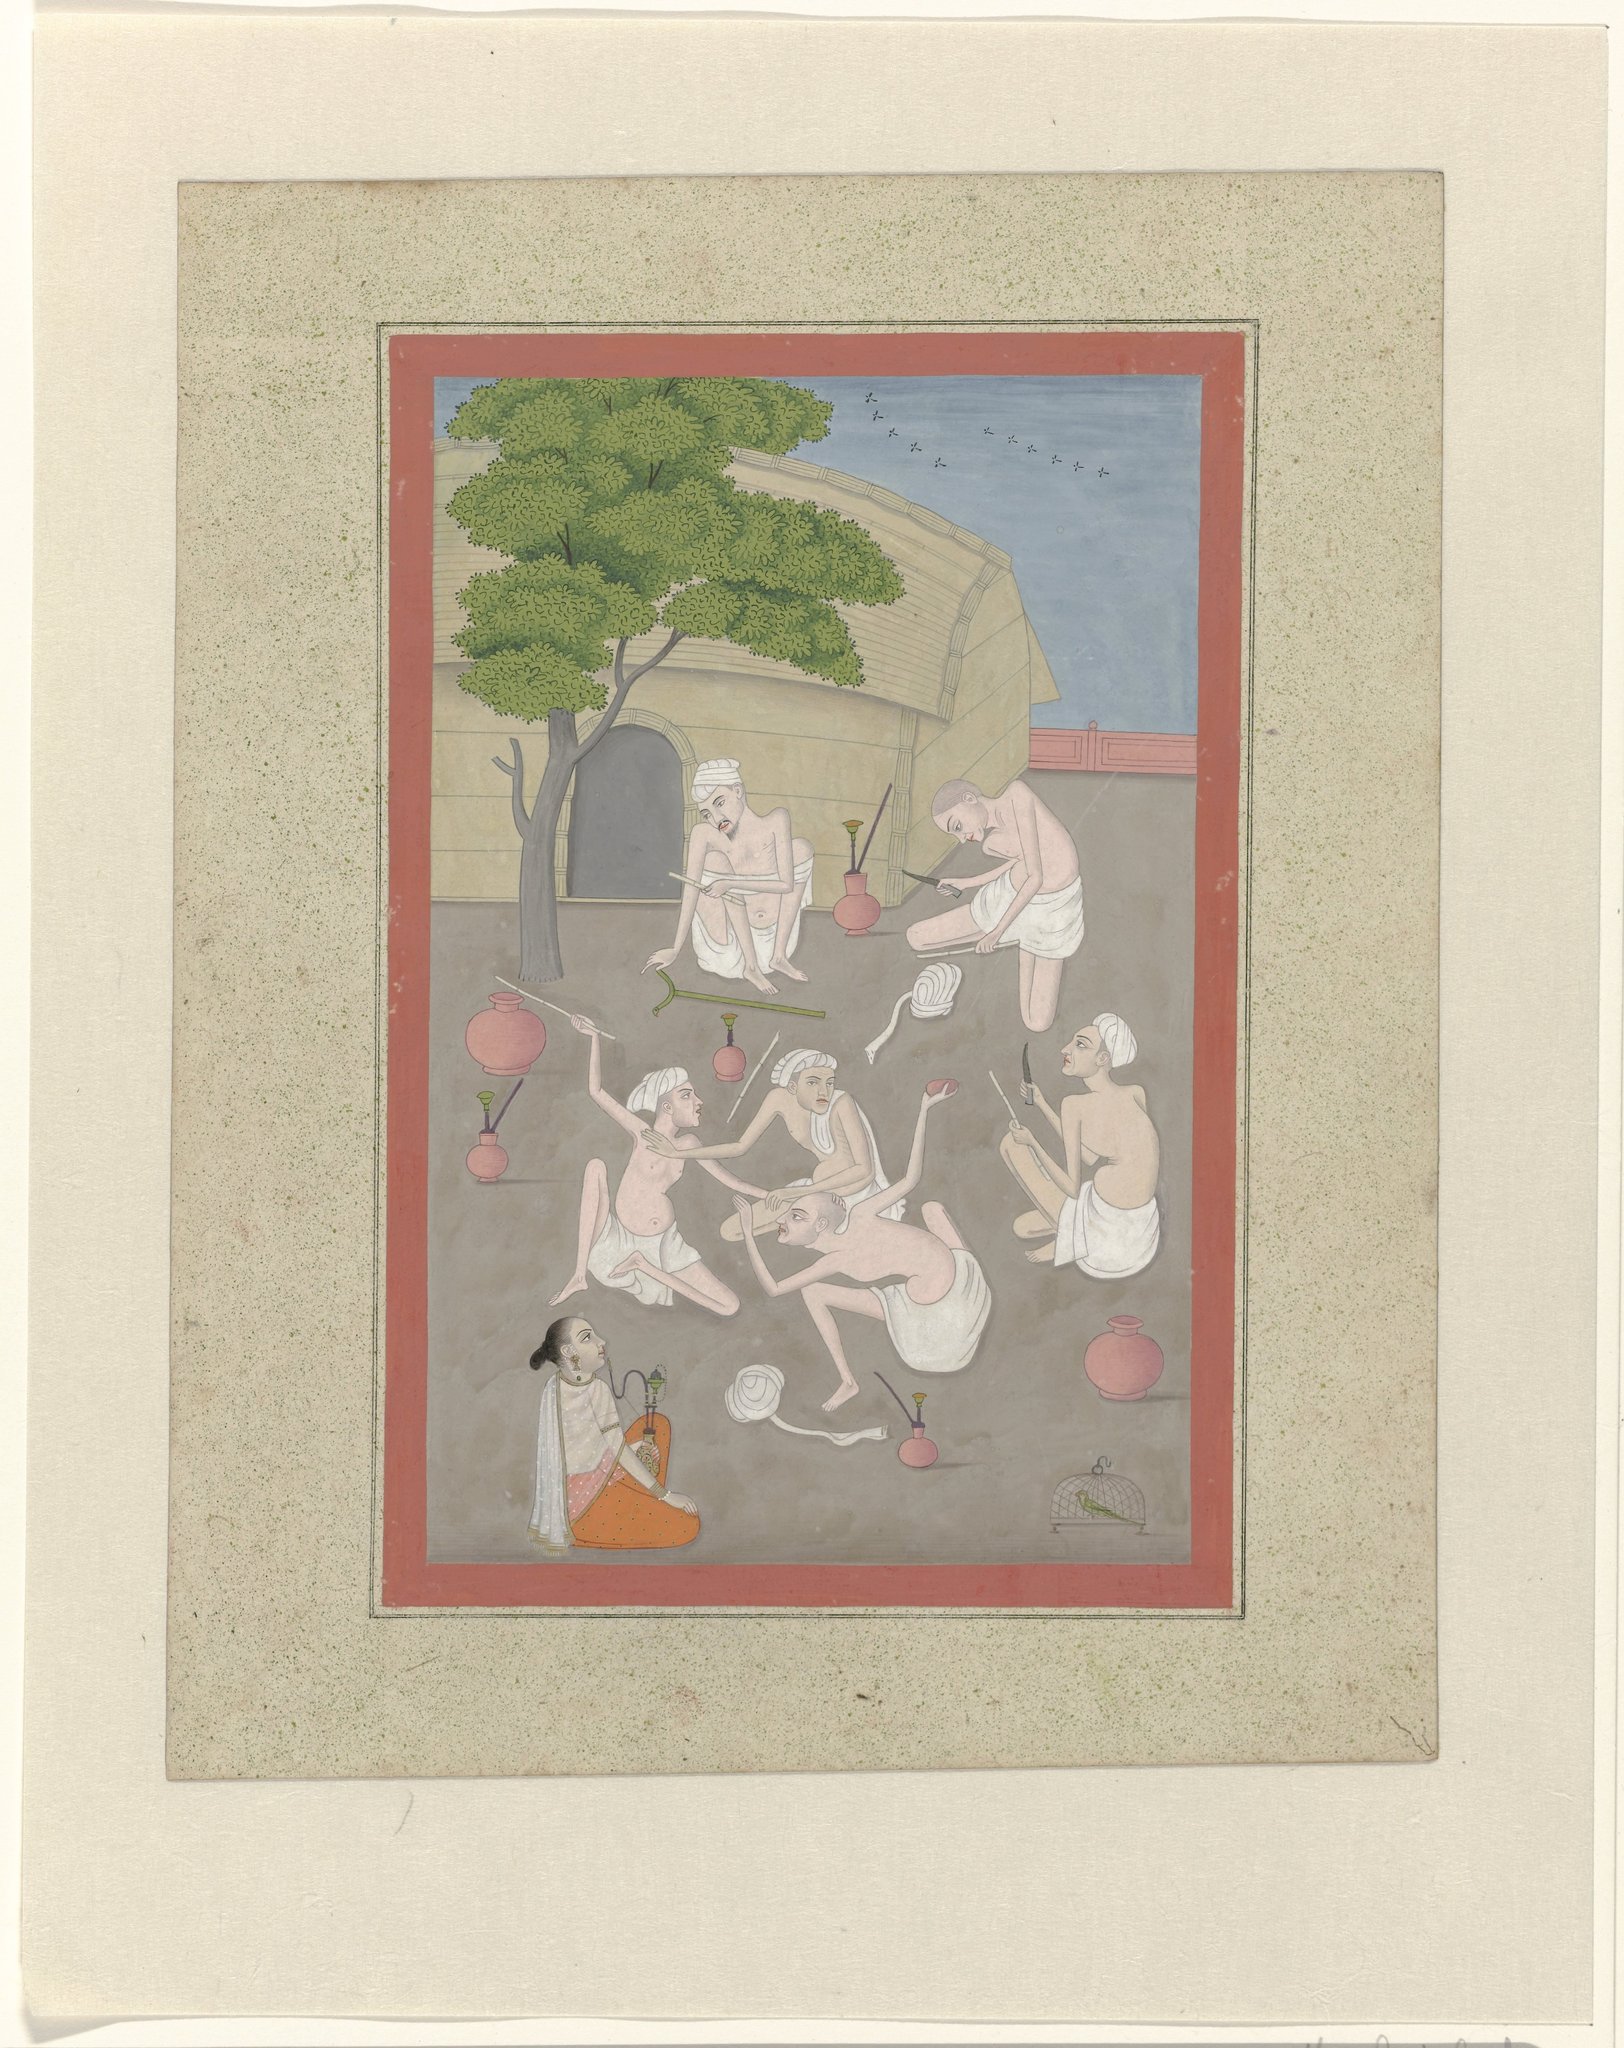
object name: drawing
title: Vechtende yogi's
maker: Anonymous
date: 1810-1830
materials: paint, paper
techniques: brush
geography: murshidabad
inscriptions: inscription: ‘.’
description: Vechtende yogi's. Rondom de voorstelling een brede roze beschilderde rand, met een dubbel zwart kaderlijntje afgezet op een blad van groengespikkeld papier.